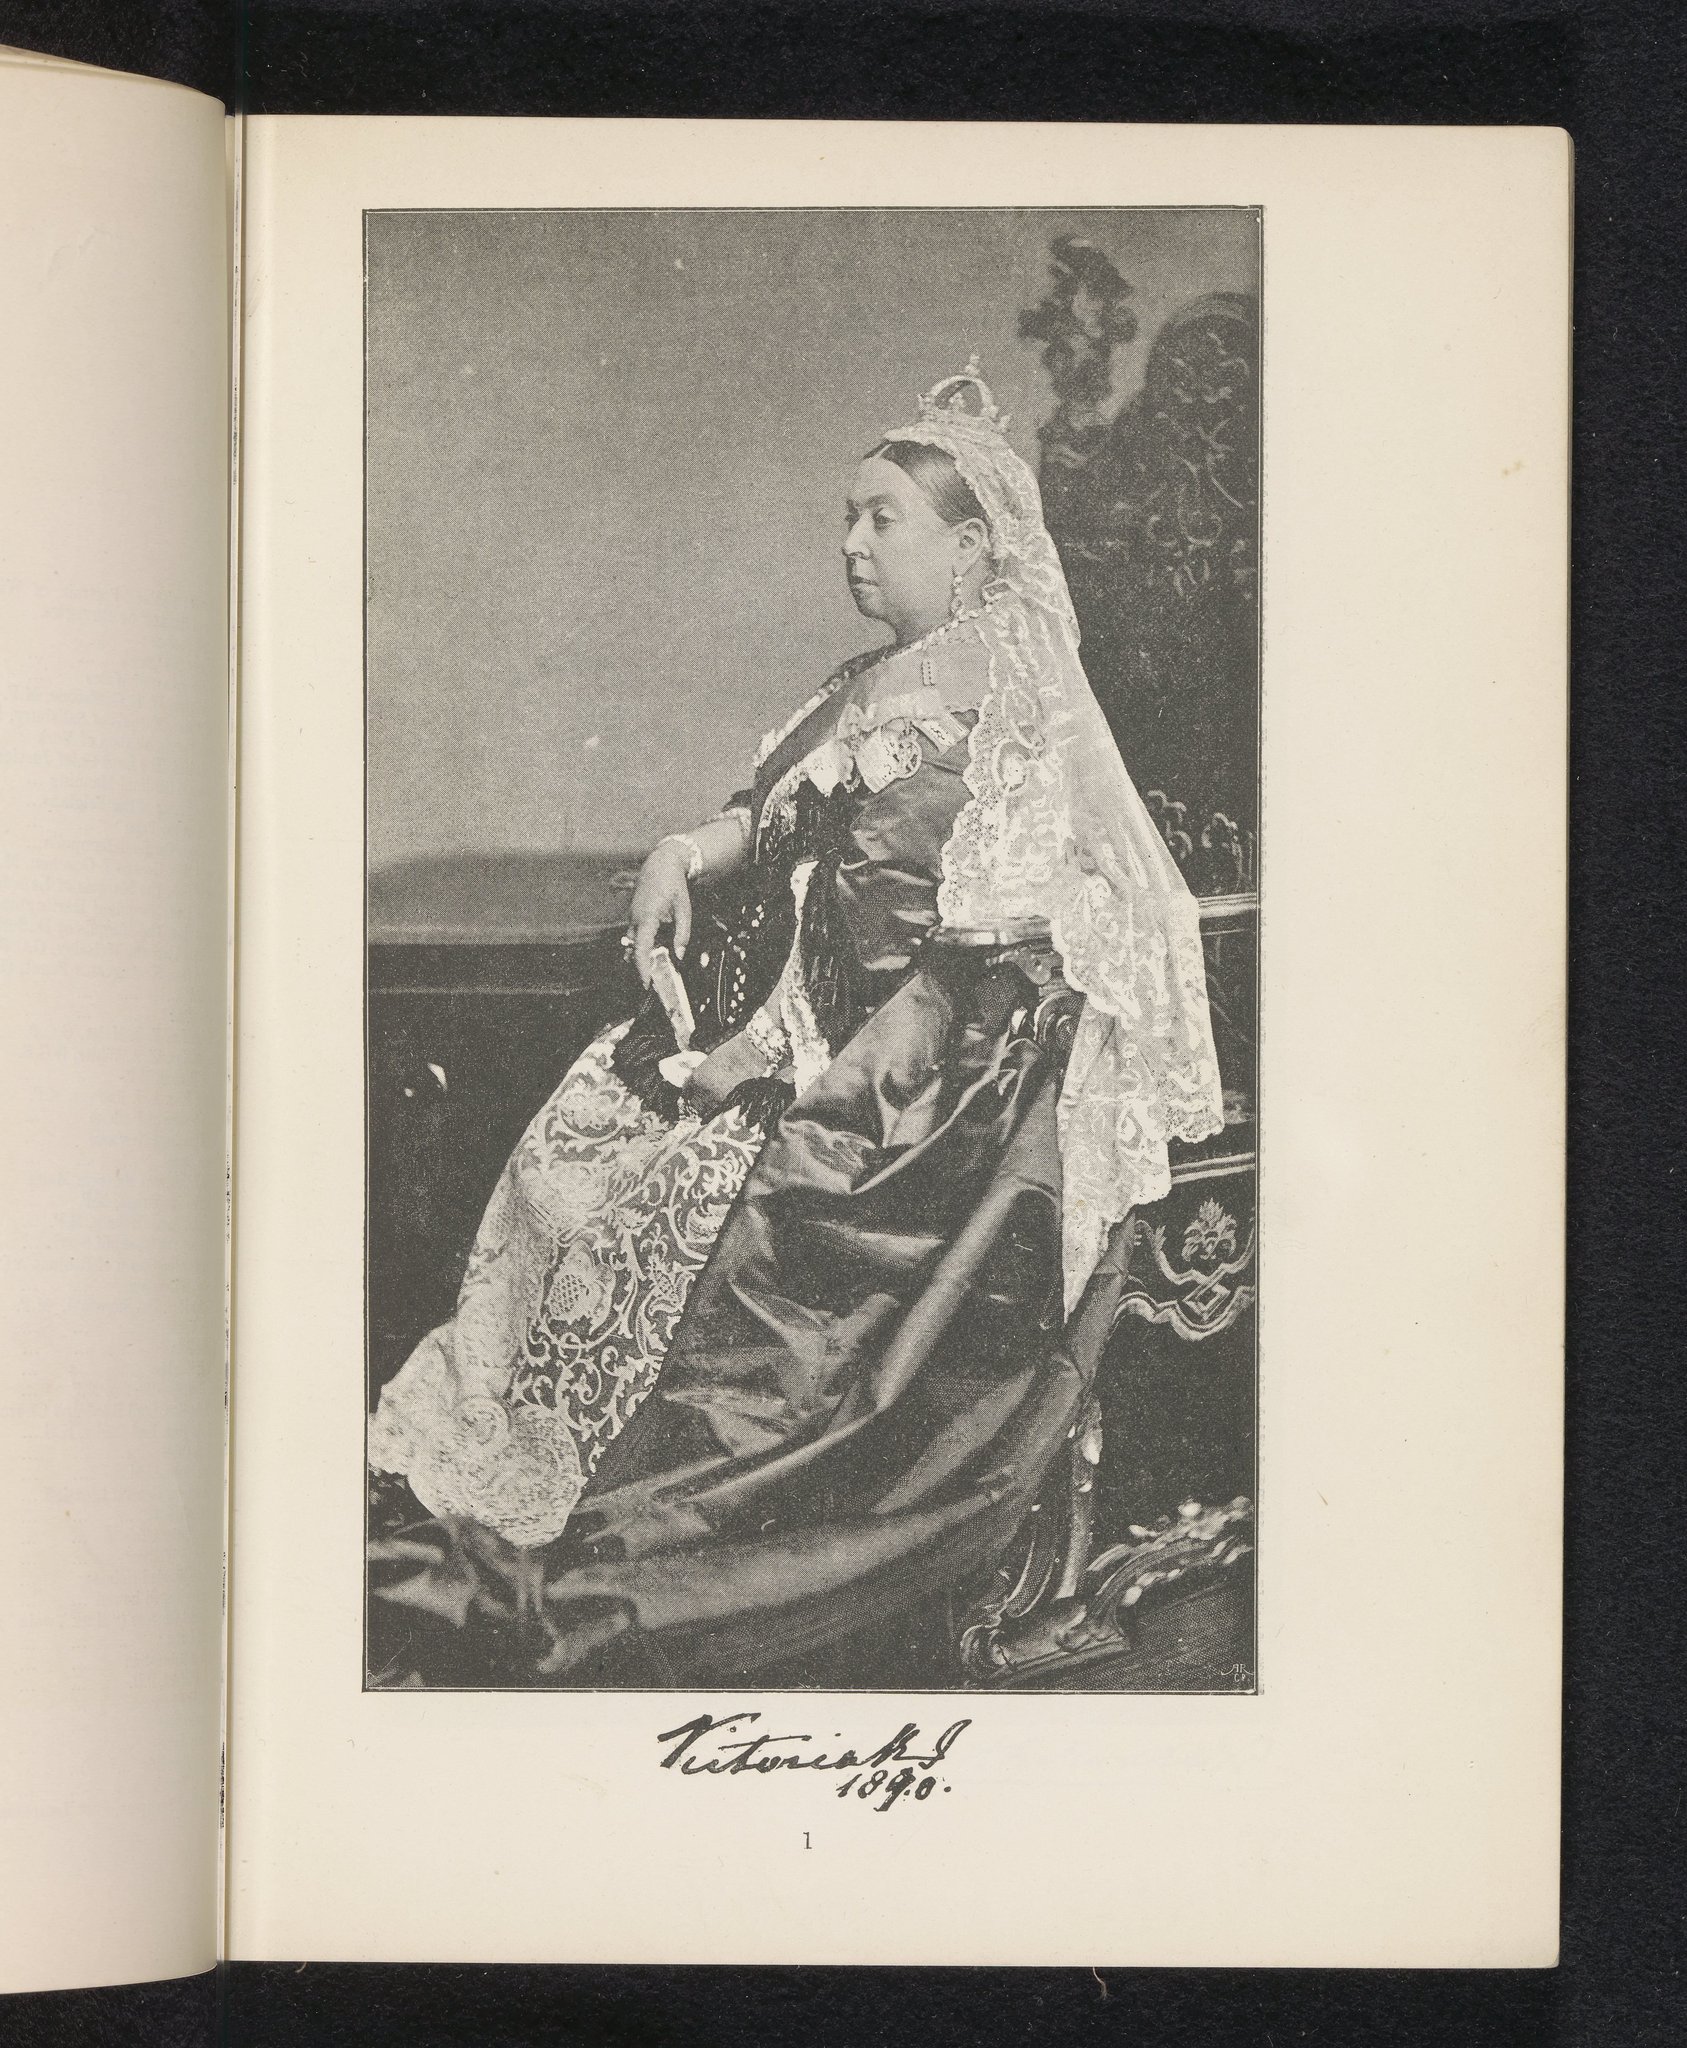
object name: photomechanical print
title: Portret van koningin Victoria van het Verenigd Koninkrijk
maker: Anonymous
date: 1881-1891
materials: paper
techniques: autotype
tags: victoria (koningin van het verenigd koninkrijk en keizerin van india), ruler, sovereign - bb - female ruler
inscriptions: inscription